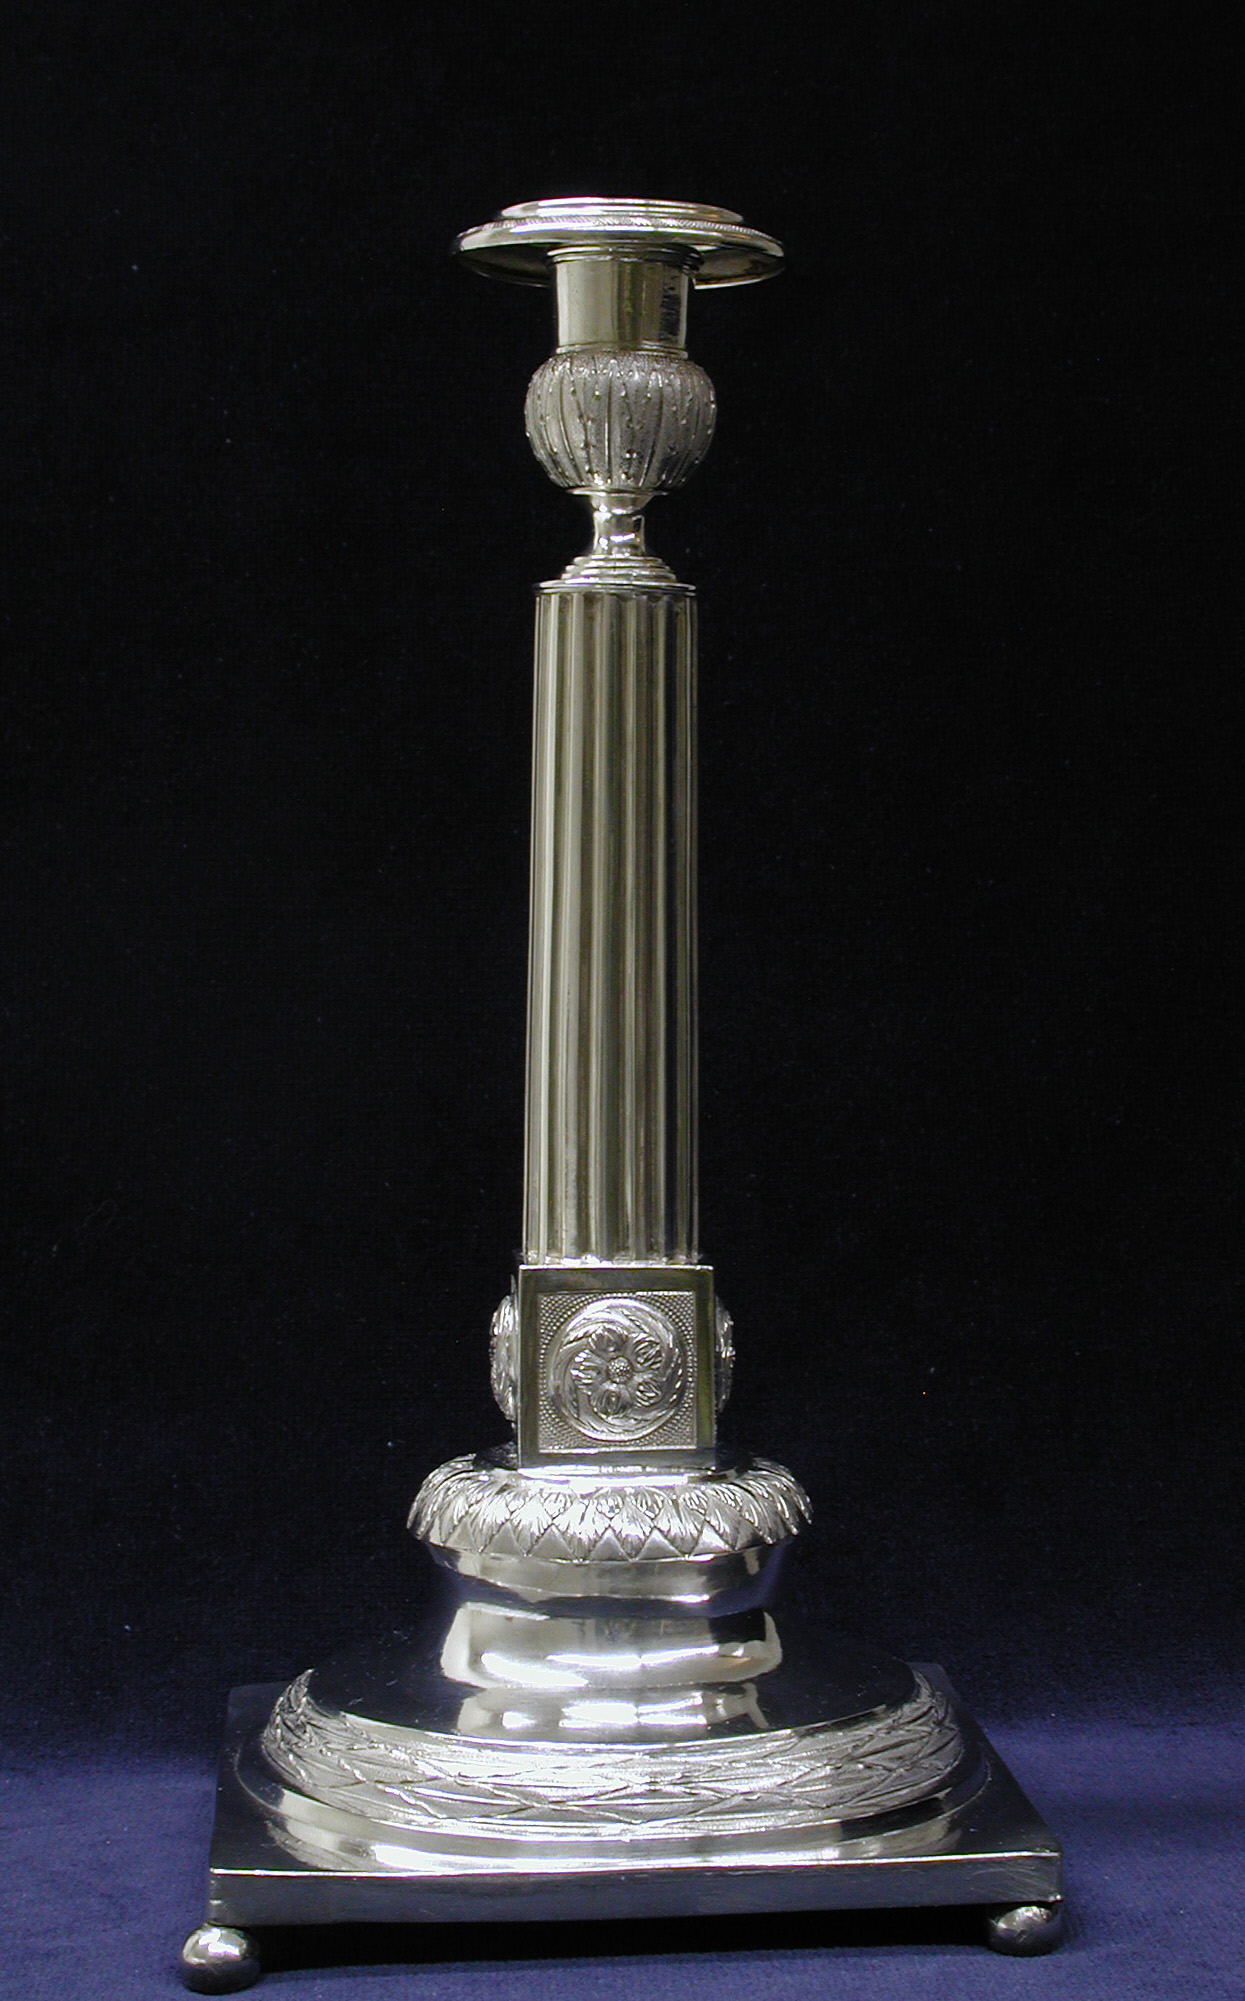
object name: candlestick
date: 1780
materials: silver